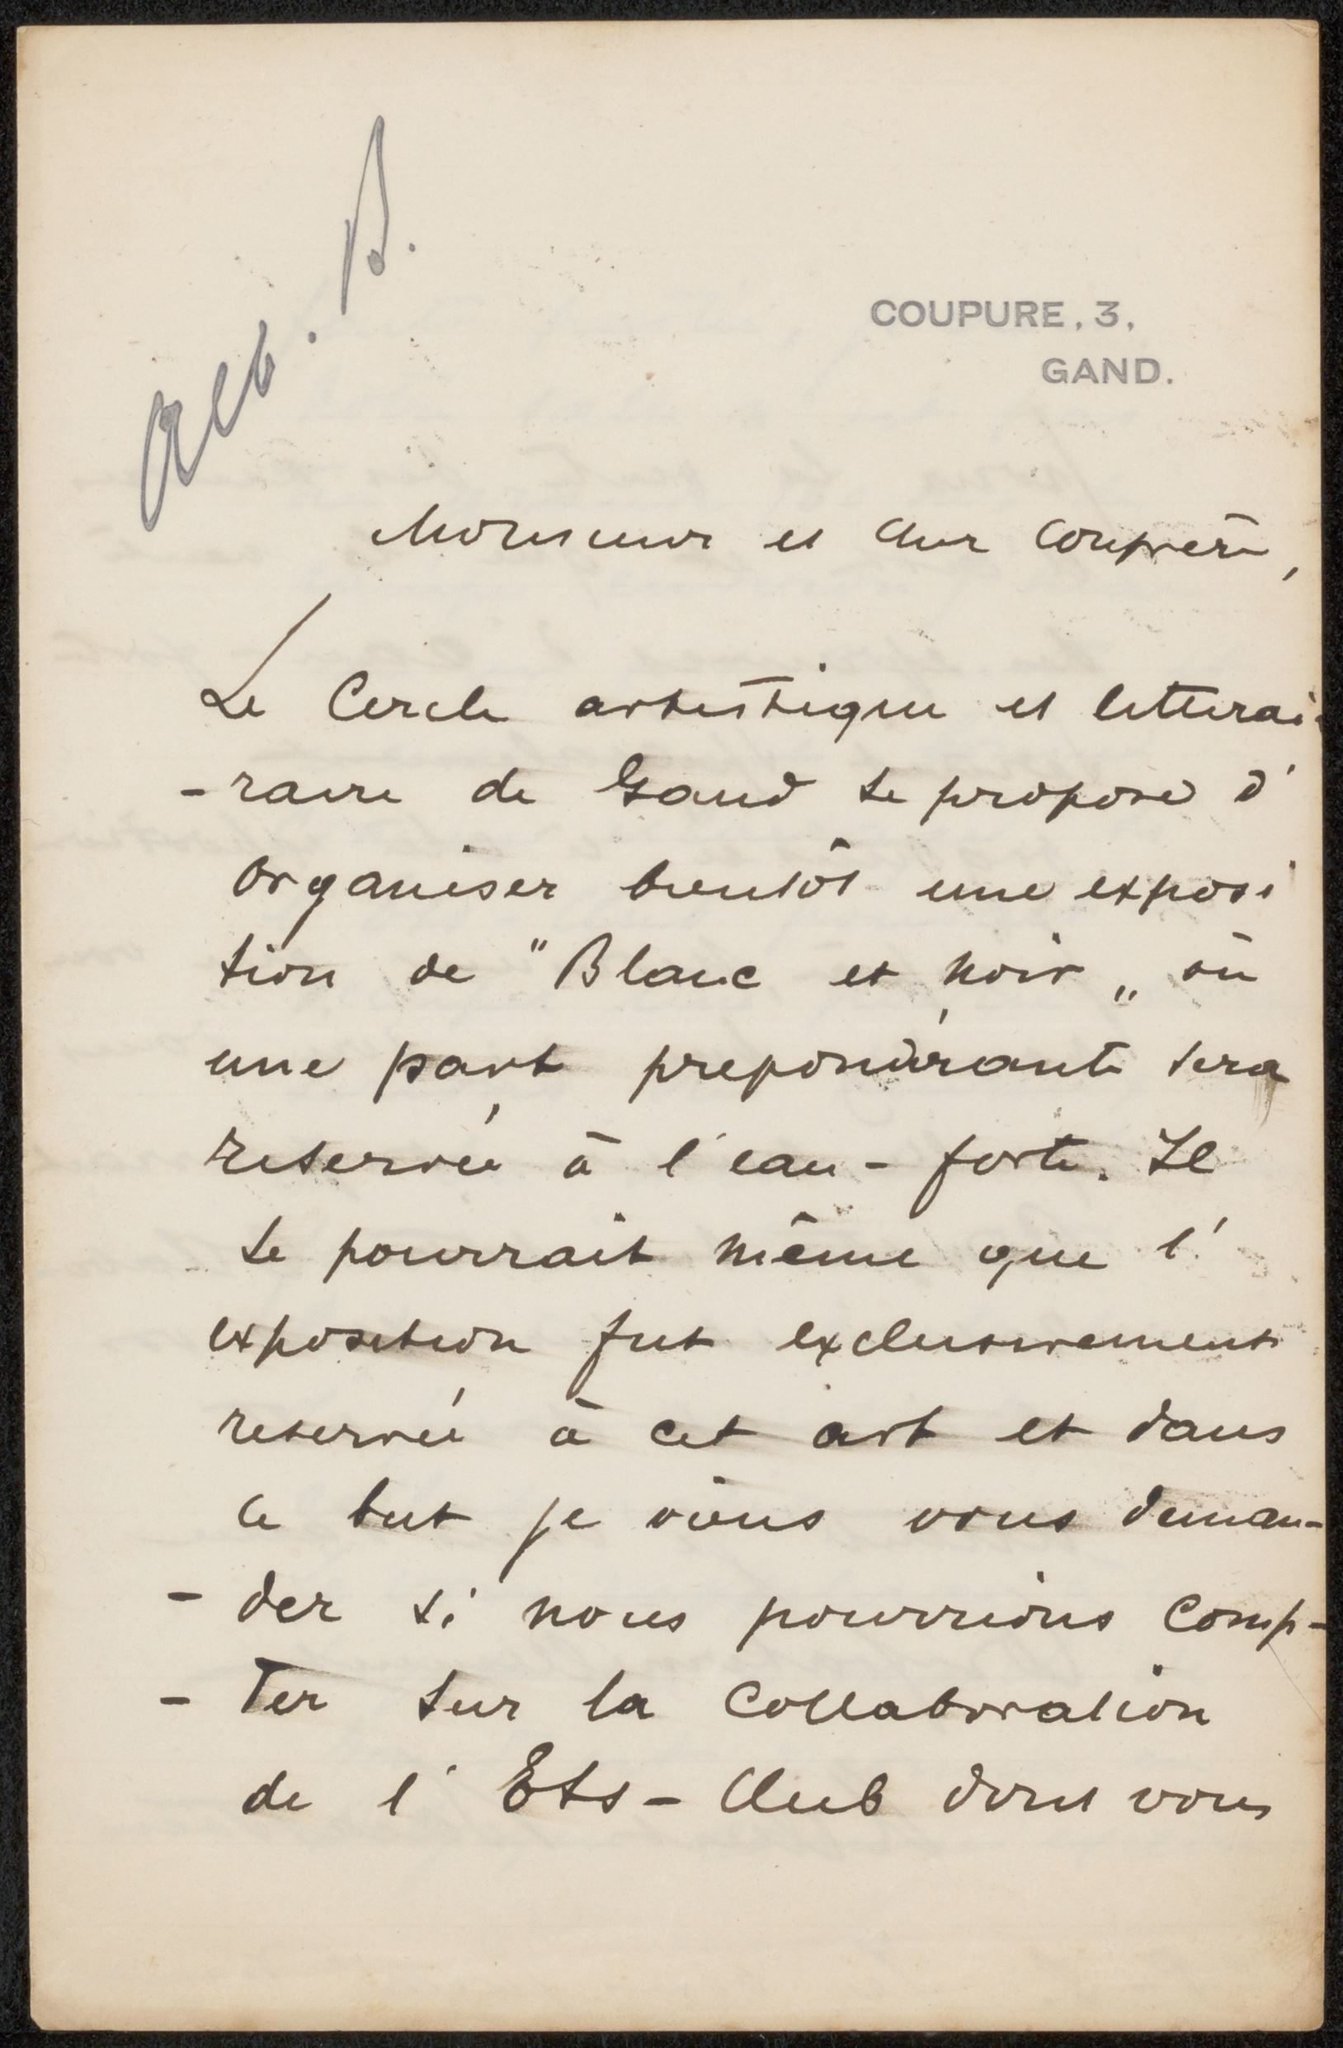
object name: letter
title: Brief aan Philip Zilcken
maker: albert baertsoen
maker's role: draughtsman, print maker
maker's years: 1866-1922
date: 1876-1922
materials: ink, paper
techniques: pen, printing, writing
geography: ghent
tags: the hague, philip zilcken, the graphic arts, temporary exhibition, 'salon'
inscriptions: collector's mark: ‘RPK’